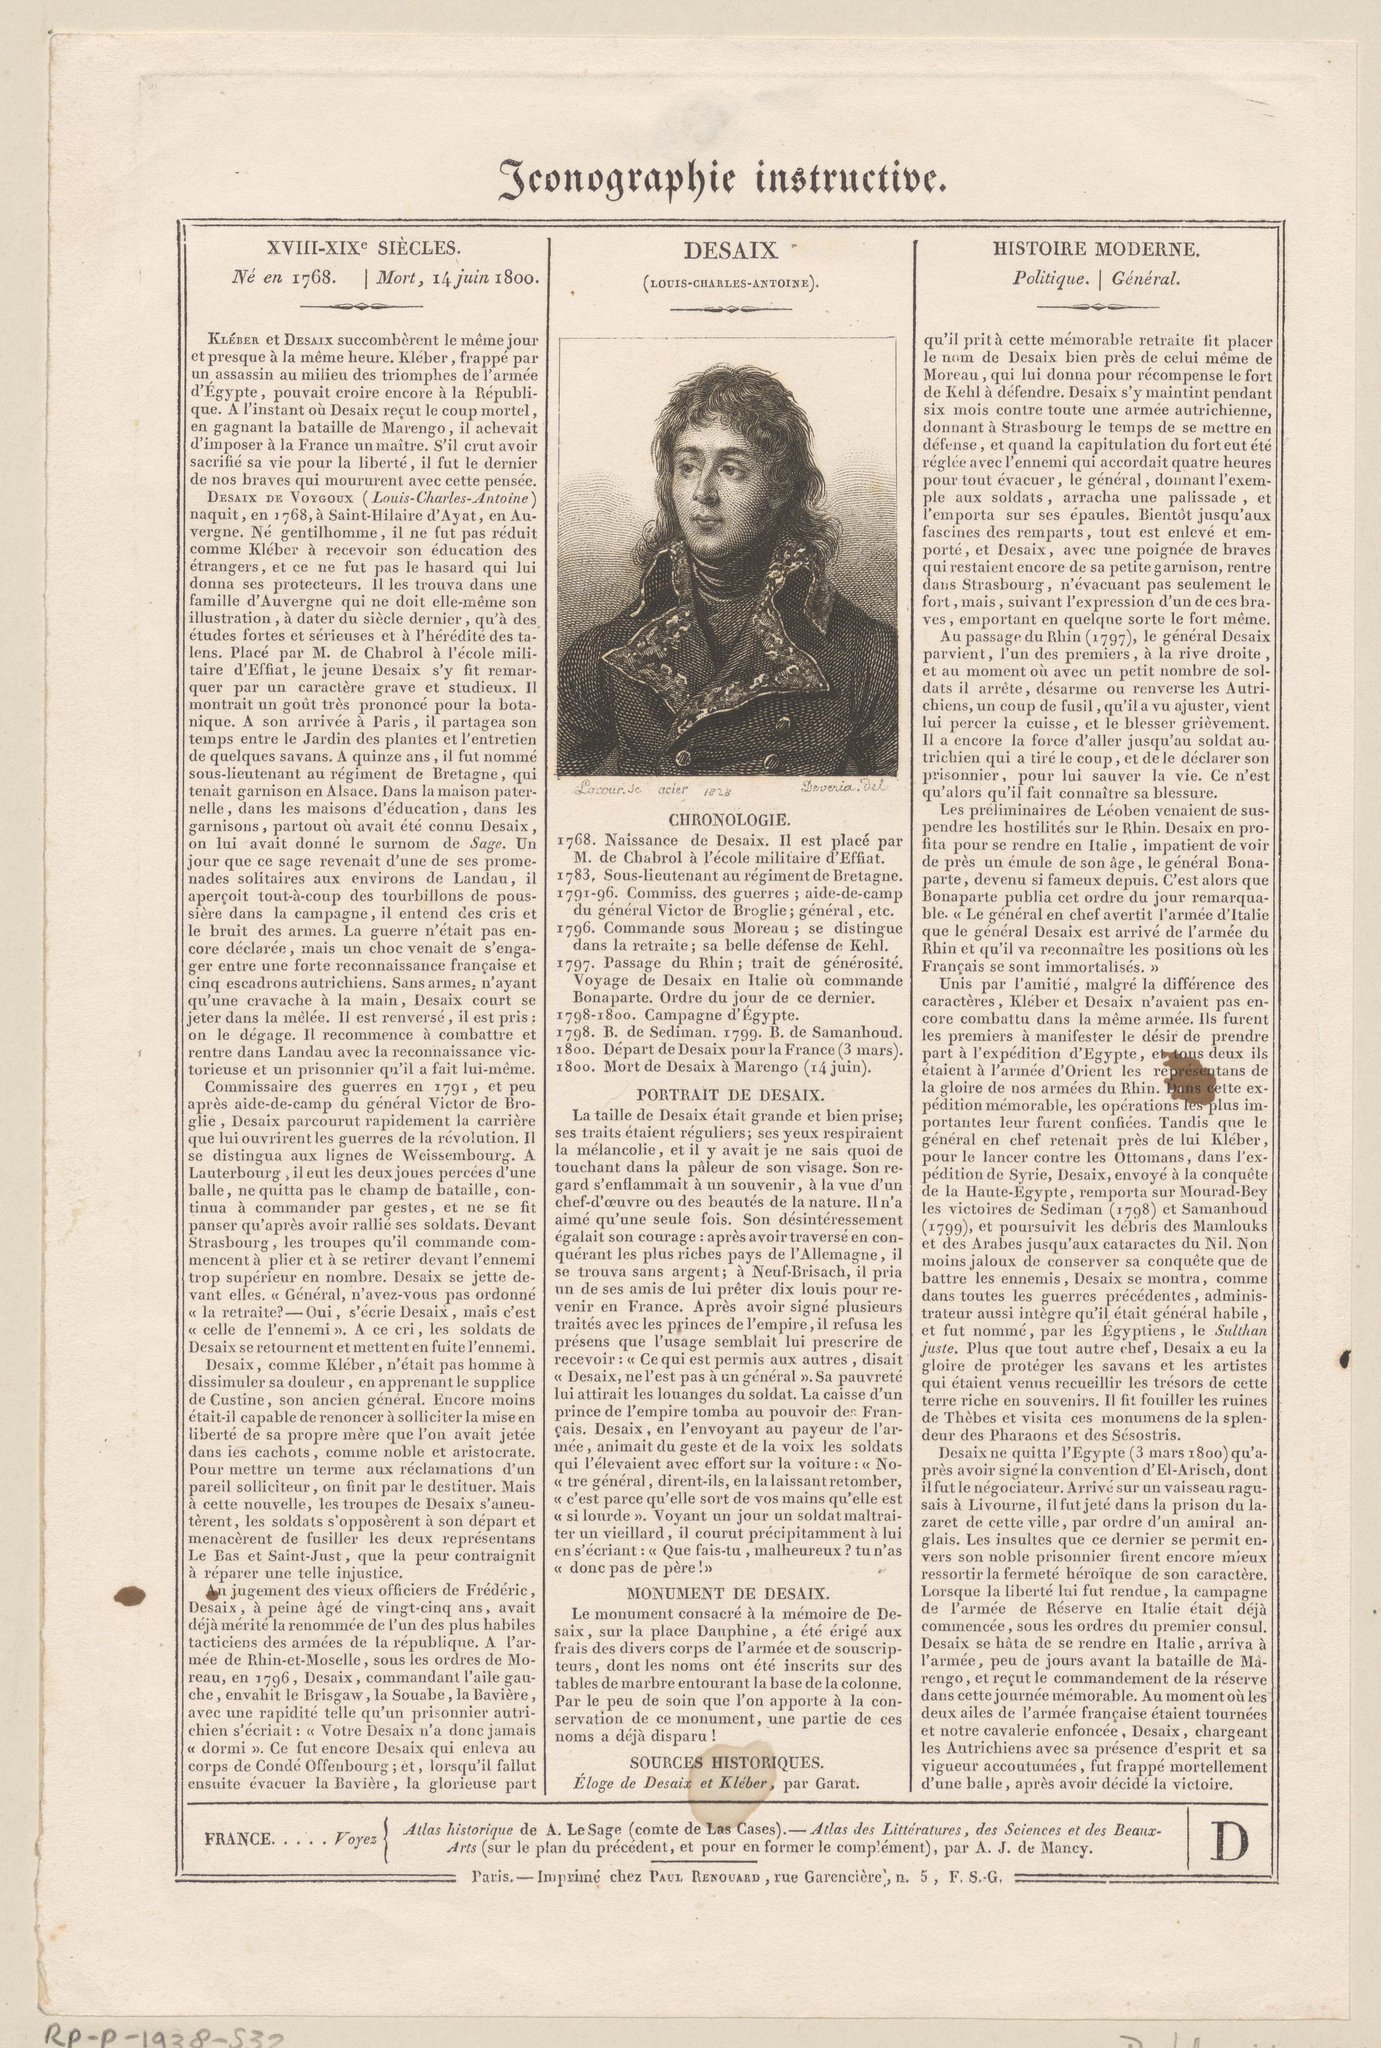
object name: book illustration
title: Portret van Louis Charles Antoine Desaix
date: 1828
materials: paper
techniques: engraving, letterpress printing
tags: commander-in-chief, general, marshal, historical persons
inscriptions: collector's mark: Lugt 2228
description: Prent mogelijk uit: Jarry de Mancy, Adrien. Iconographie instructive, ou Collection de portraits des personnages les plus célèbres de l'histoire moderne (...). Parijs: s.n., 1827-1828.